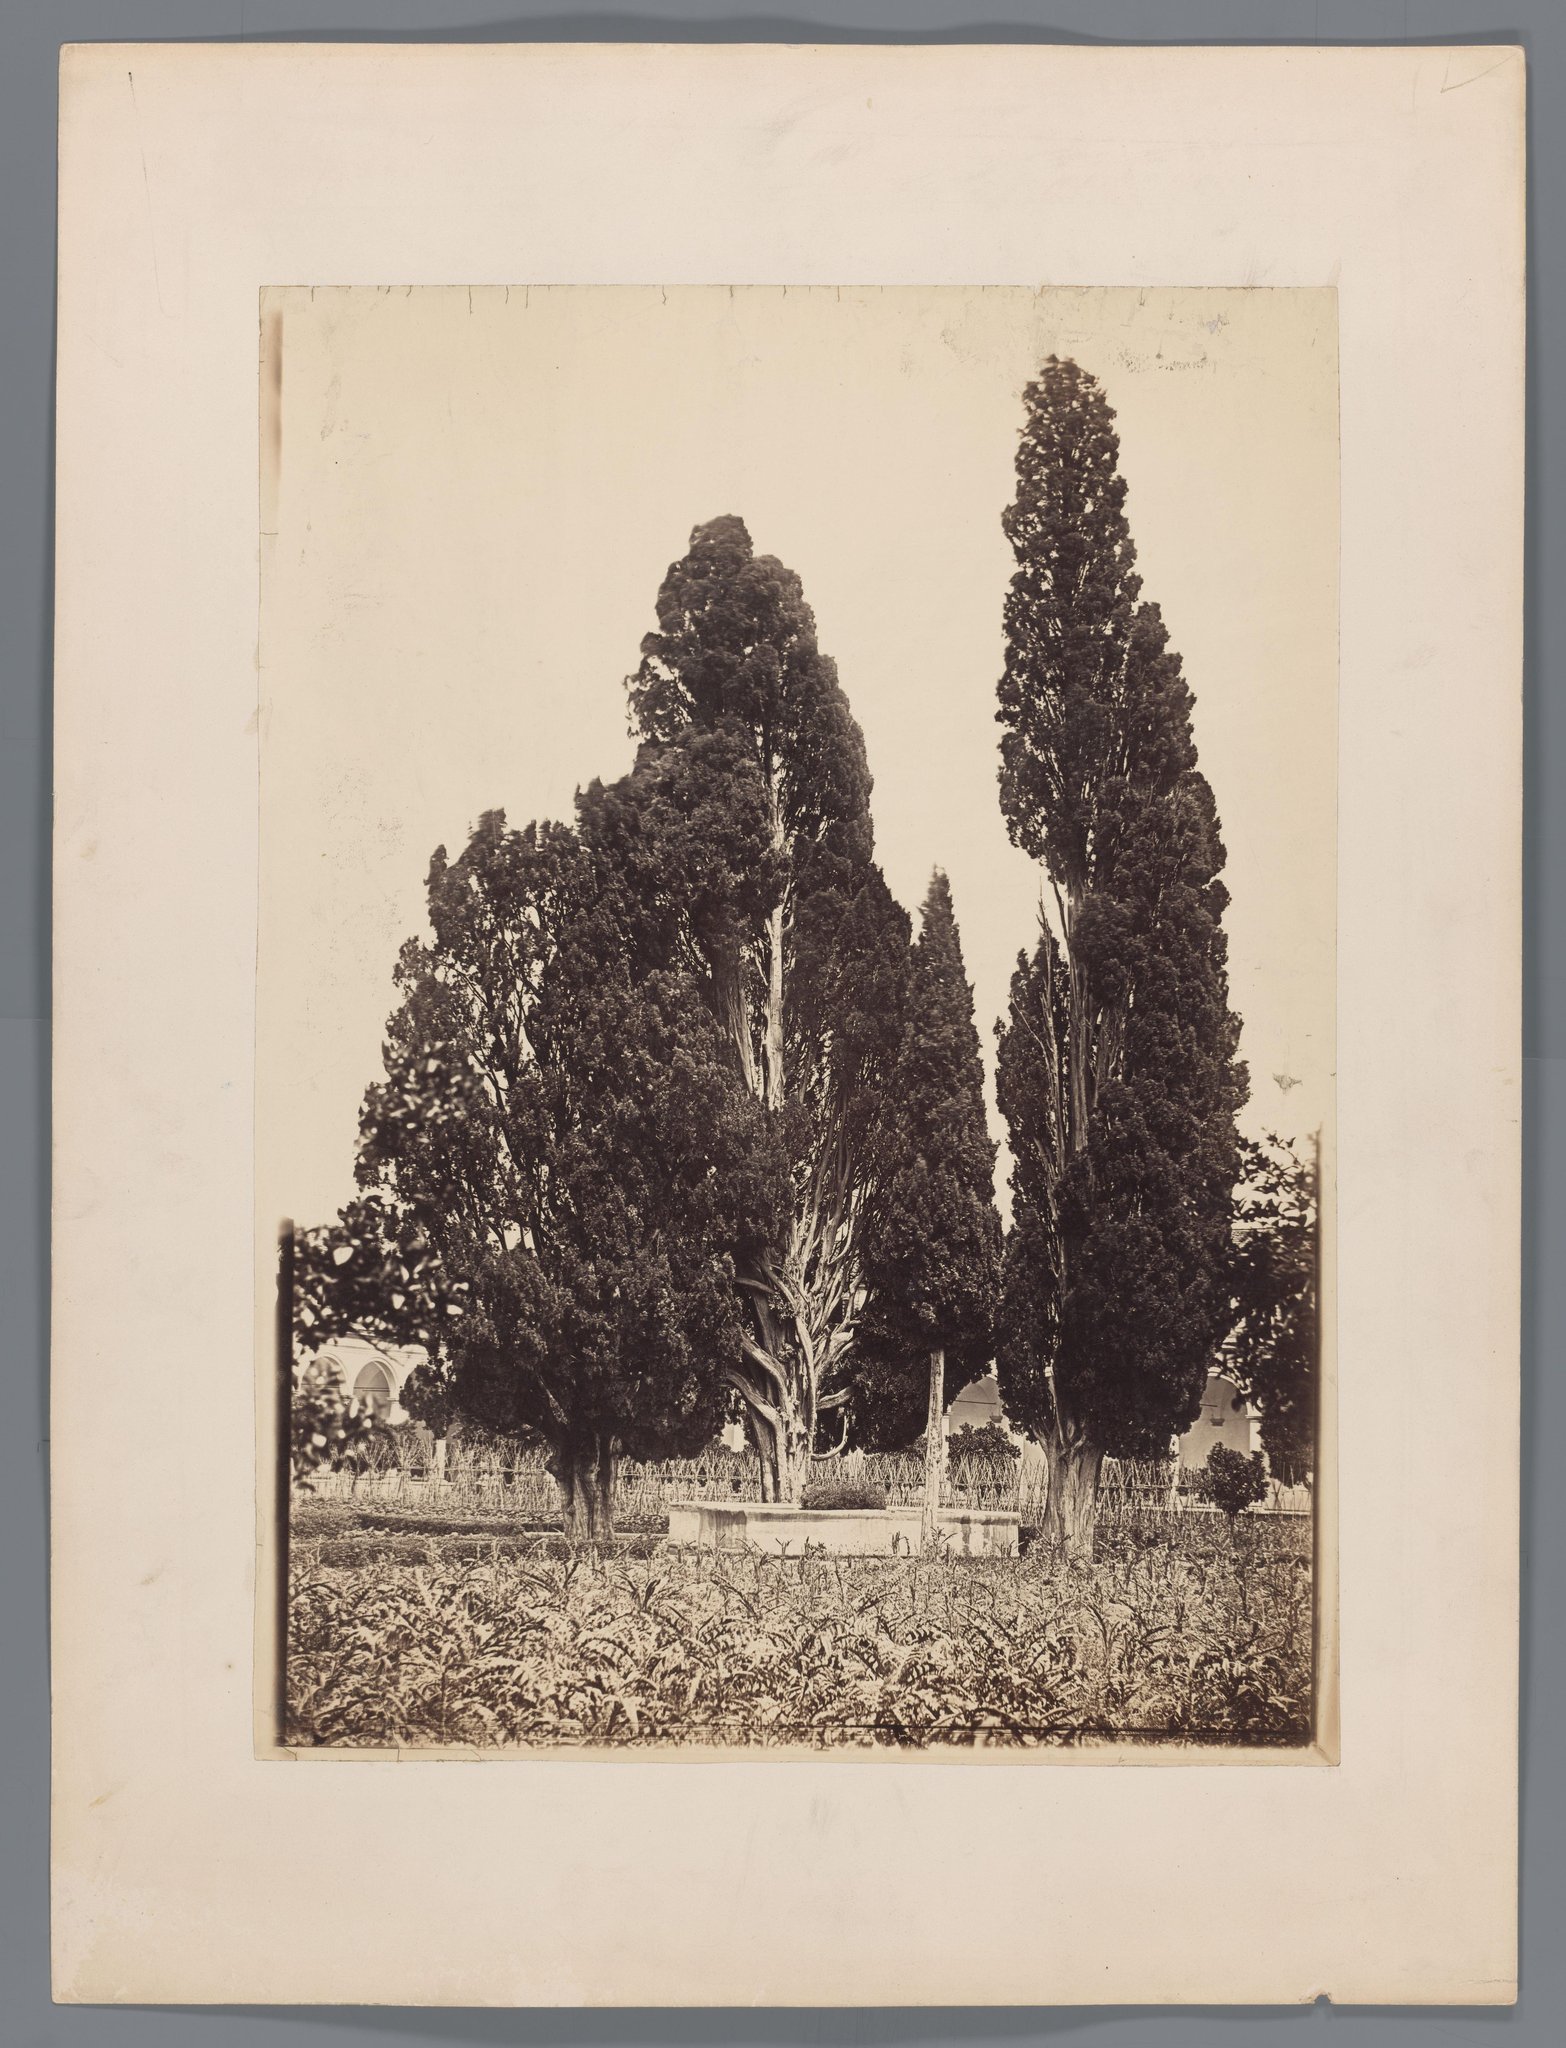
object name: photograph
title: Boomstudie, te Rome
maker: gustave eugène chauffourier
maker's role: fotograaf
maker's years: 1845-1919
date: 1857-1875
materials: cardboard, paper, photographic support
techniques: albumen print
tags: rome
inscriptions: stamp: ‘Rijksschool voor Kunstnijverheid’